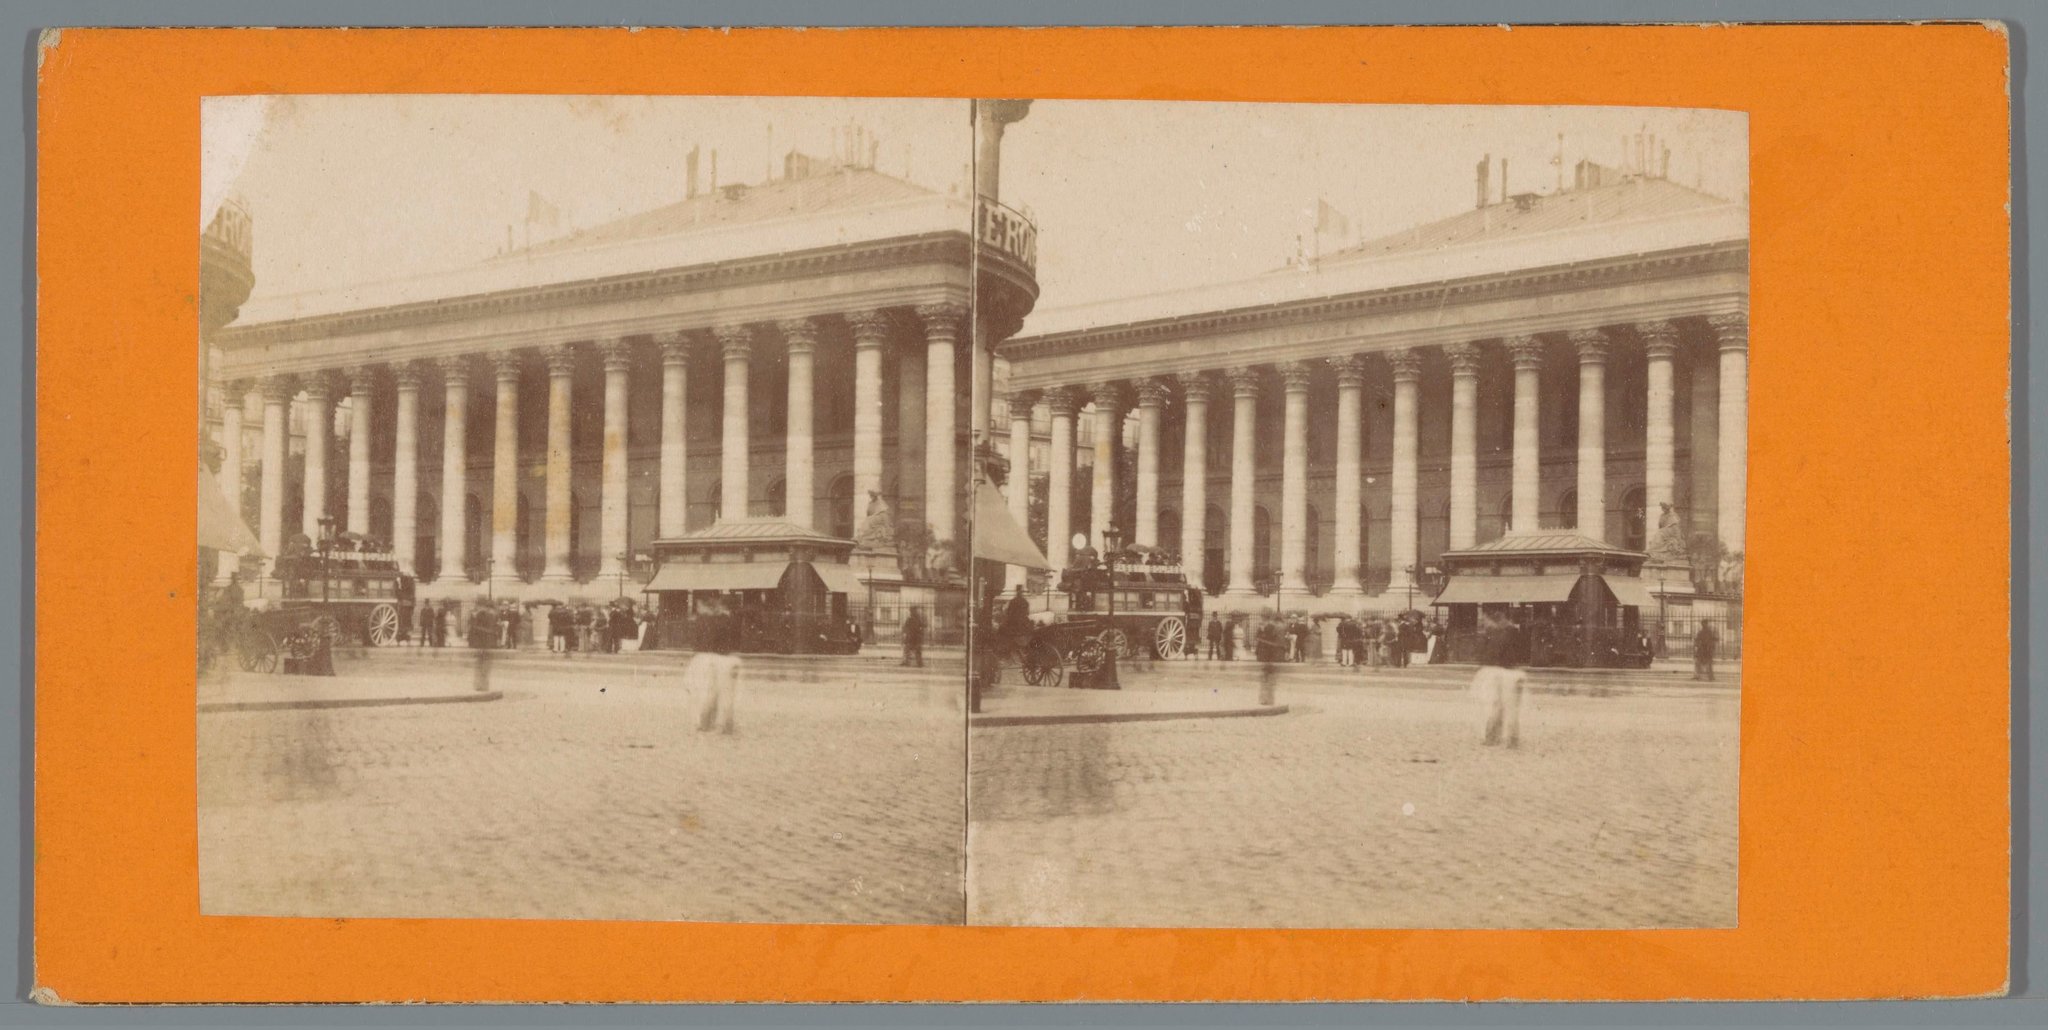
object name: stereograph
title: Gezicht op het Palais de la Bourse, oftewel het Palais Brongniart in Parijs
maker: Anonymous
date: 1850-1880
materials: cardboard, photographic support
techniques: albumen print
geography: paris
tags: façade (of house or building), exchange, bourse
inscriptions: inscription: ‘La Bourse’